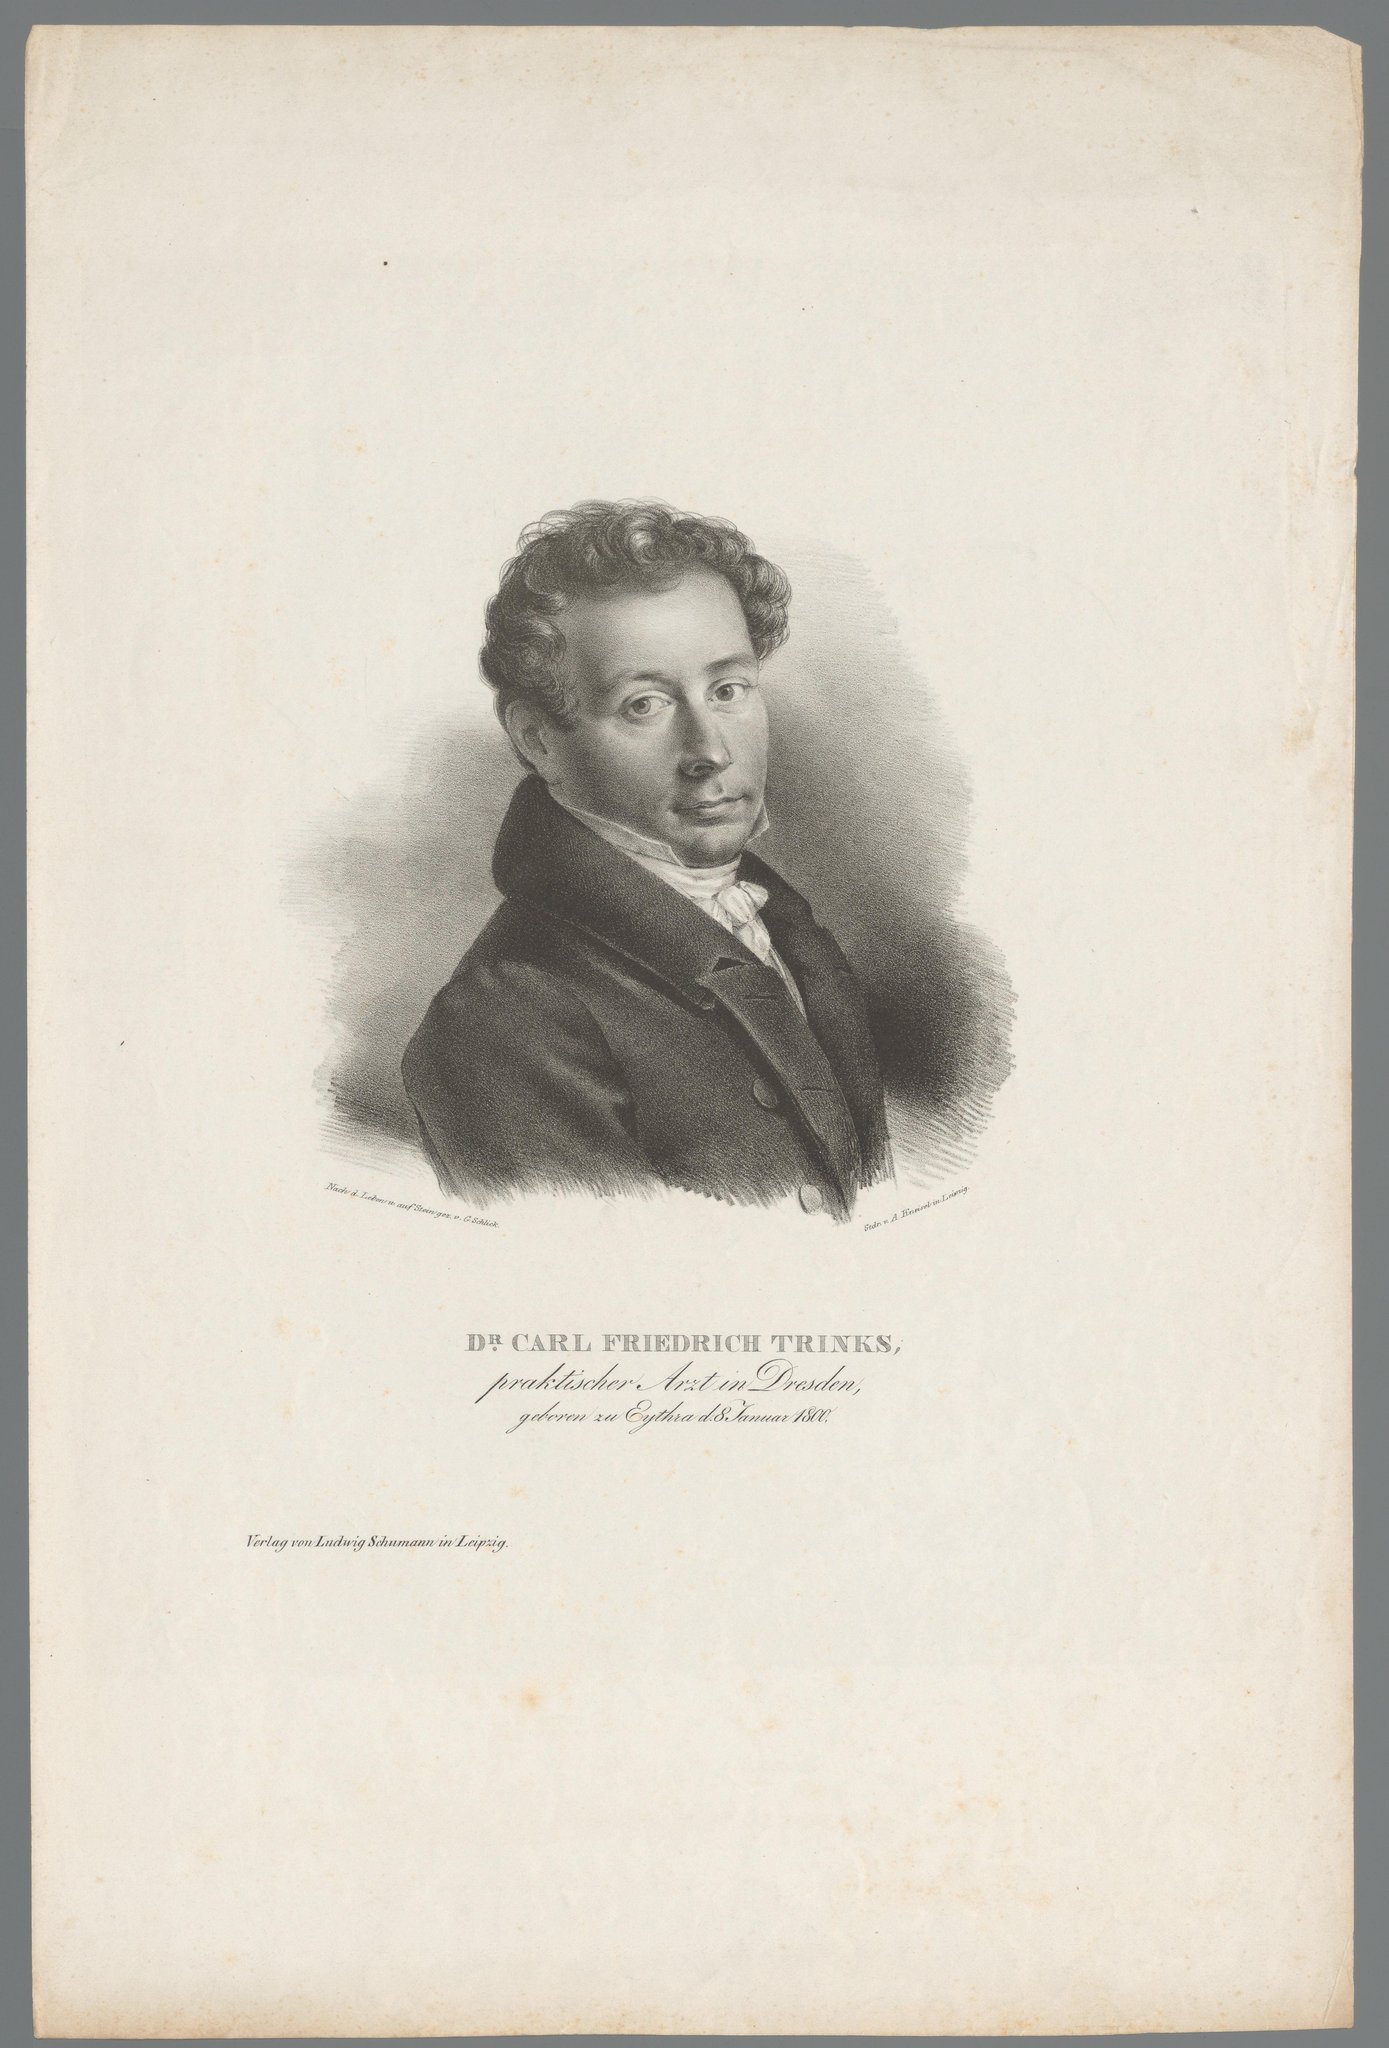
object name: print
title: Portret van Carl Friedrich Trinks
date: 1814-1855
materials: paper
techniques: lithograph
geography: leipzig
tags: historical persons, physician, doctor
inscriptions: collector's mark: Lugt 2228